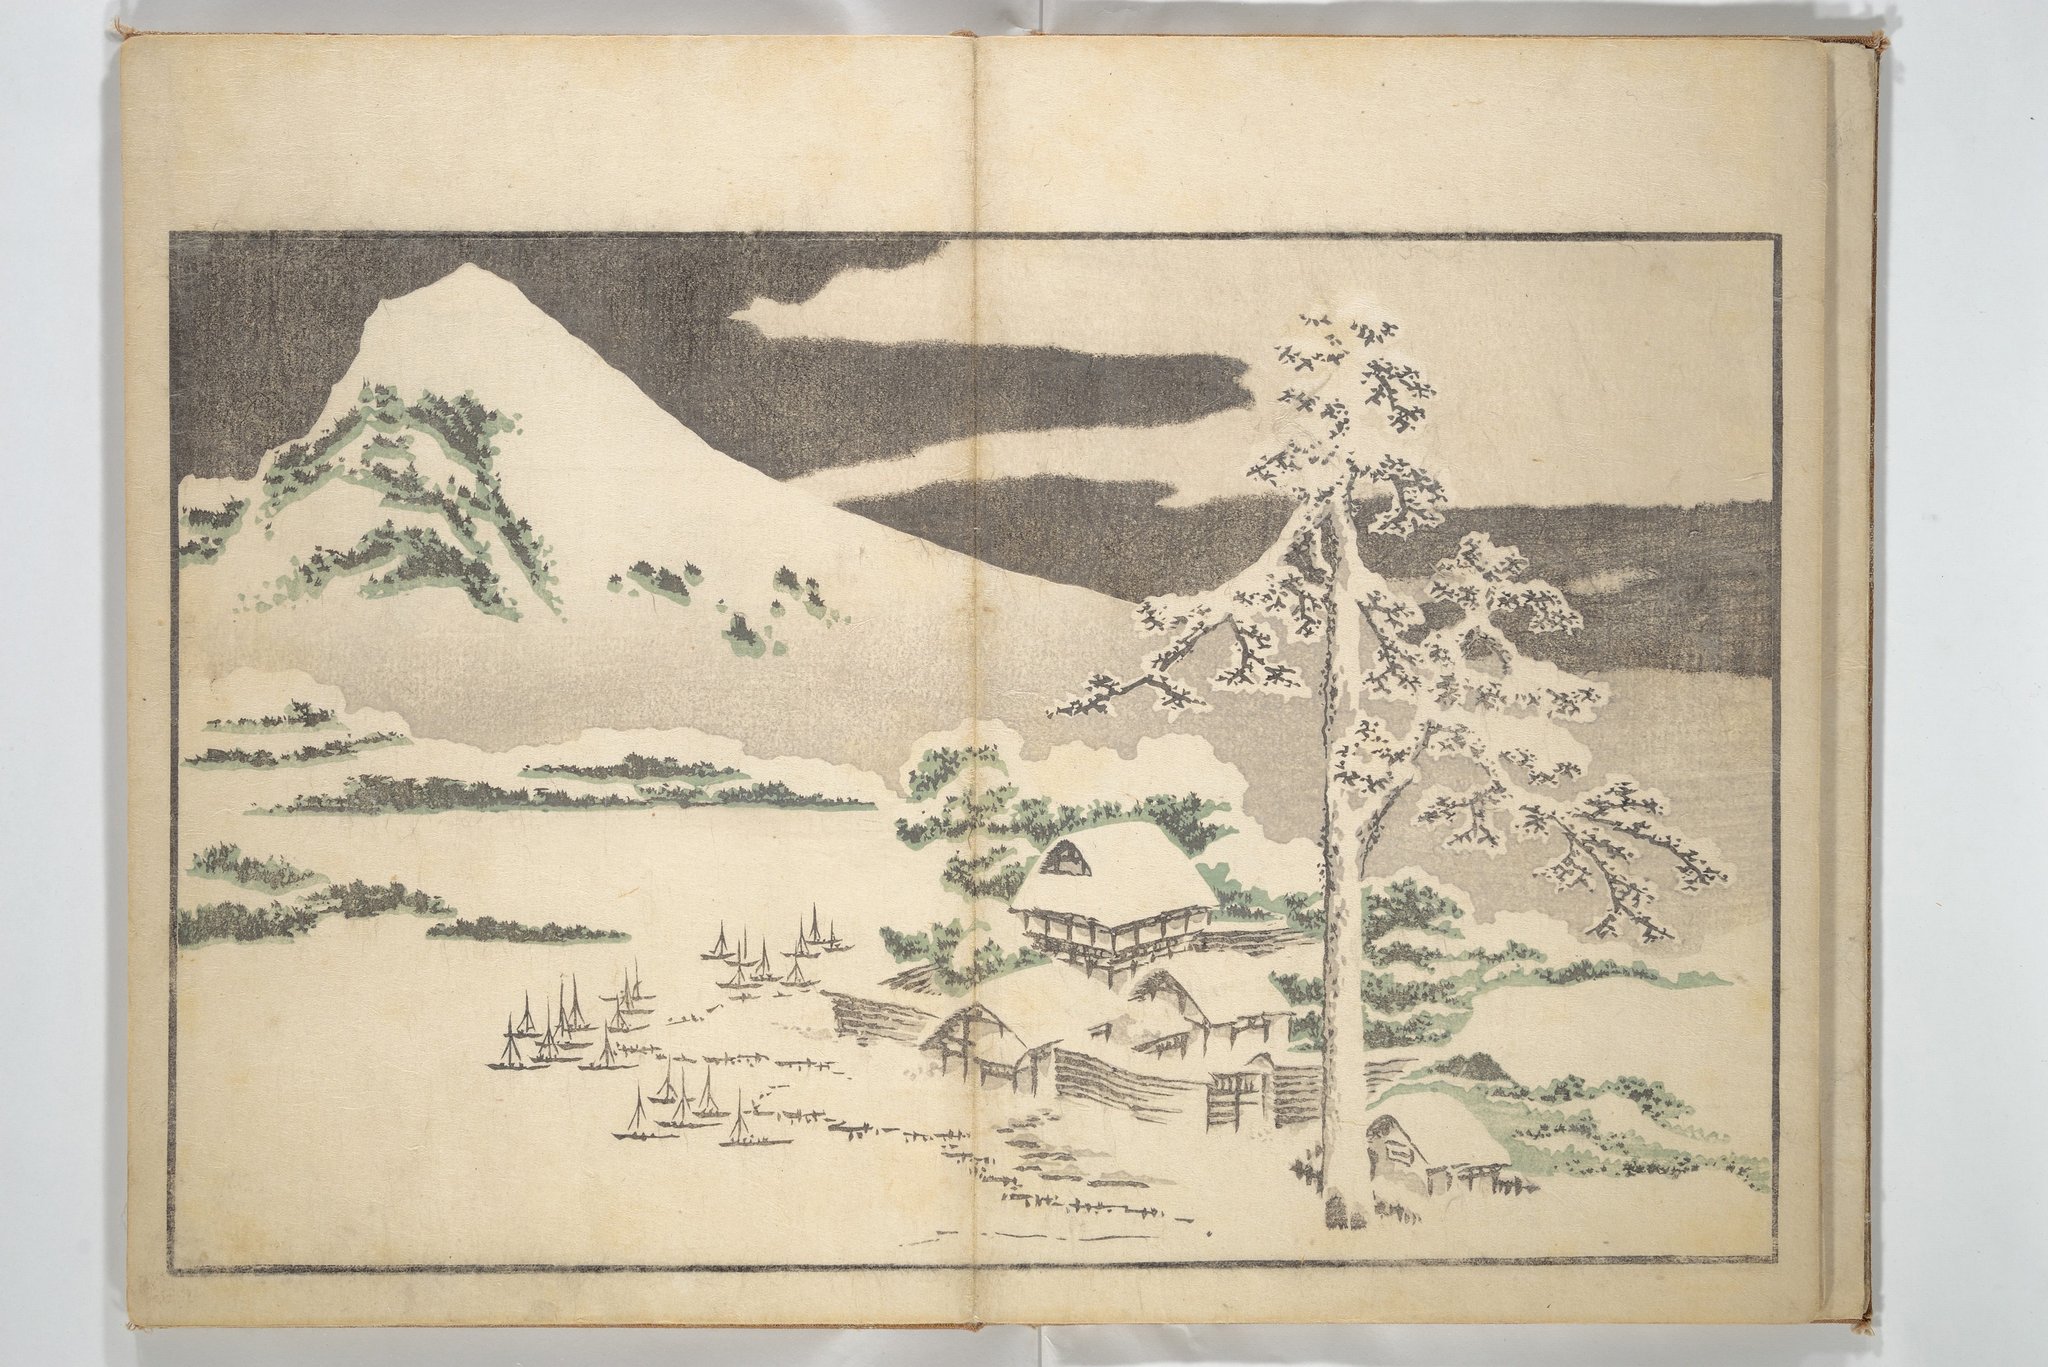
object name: illustrated book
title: A Realistic Sketchbook by Hokusai (Hokusai shashin gafu) 北斎写真画譜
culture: japanese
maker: katsushika hokusai 葛飾北斎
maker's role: artist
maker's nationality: japanese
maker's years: 1760-1849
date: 1814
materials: ink, paper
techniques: woodblock print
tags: houses,mountains,snow